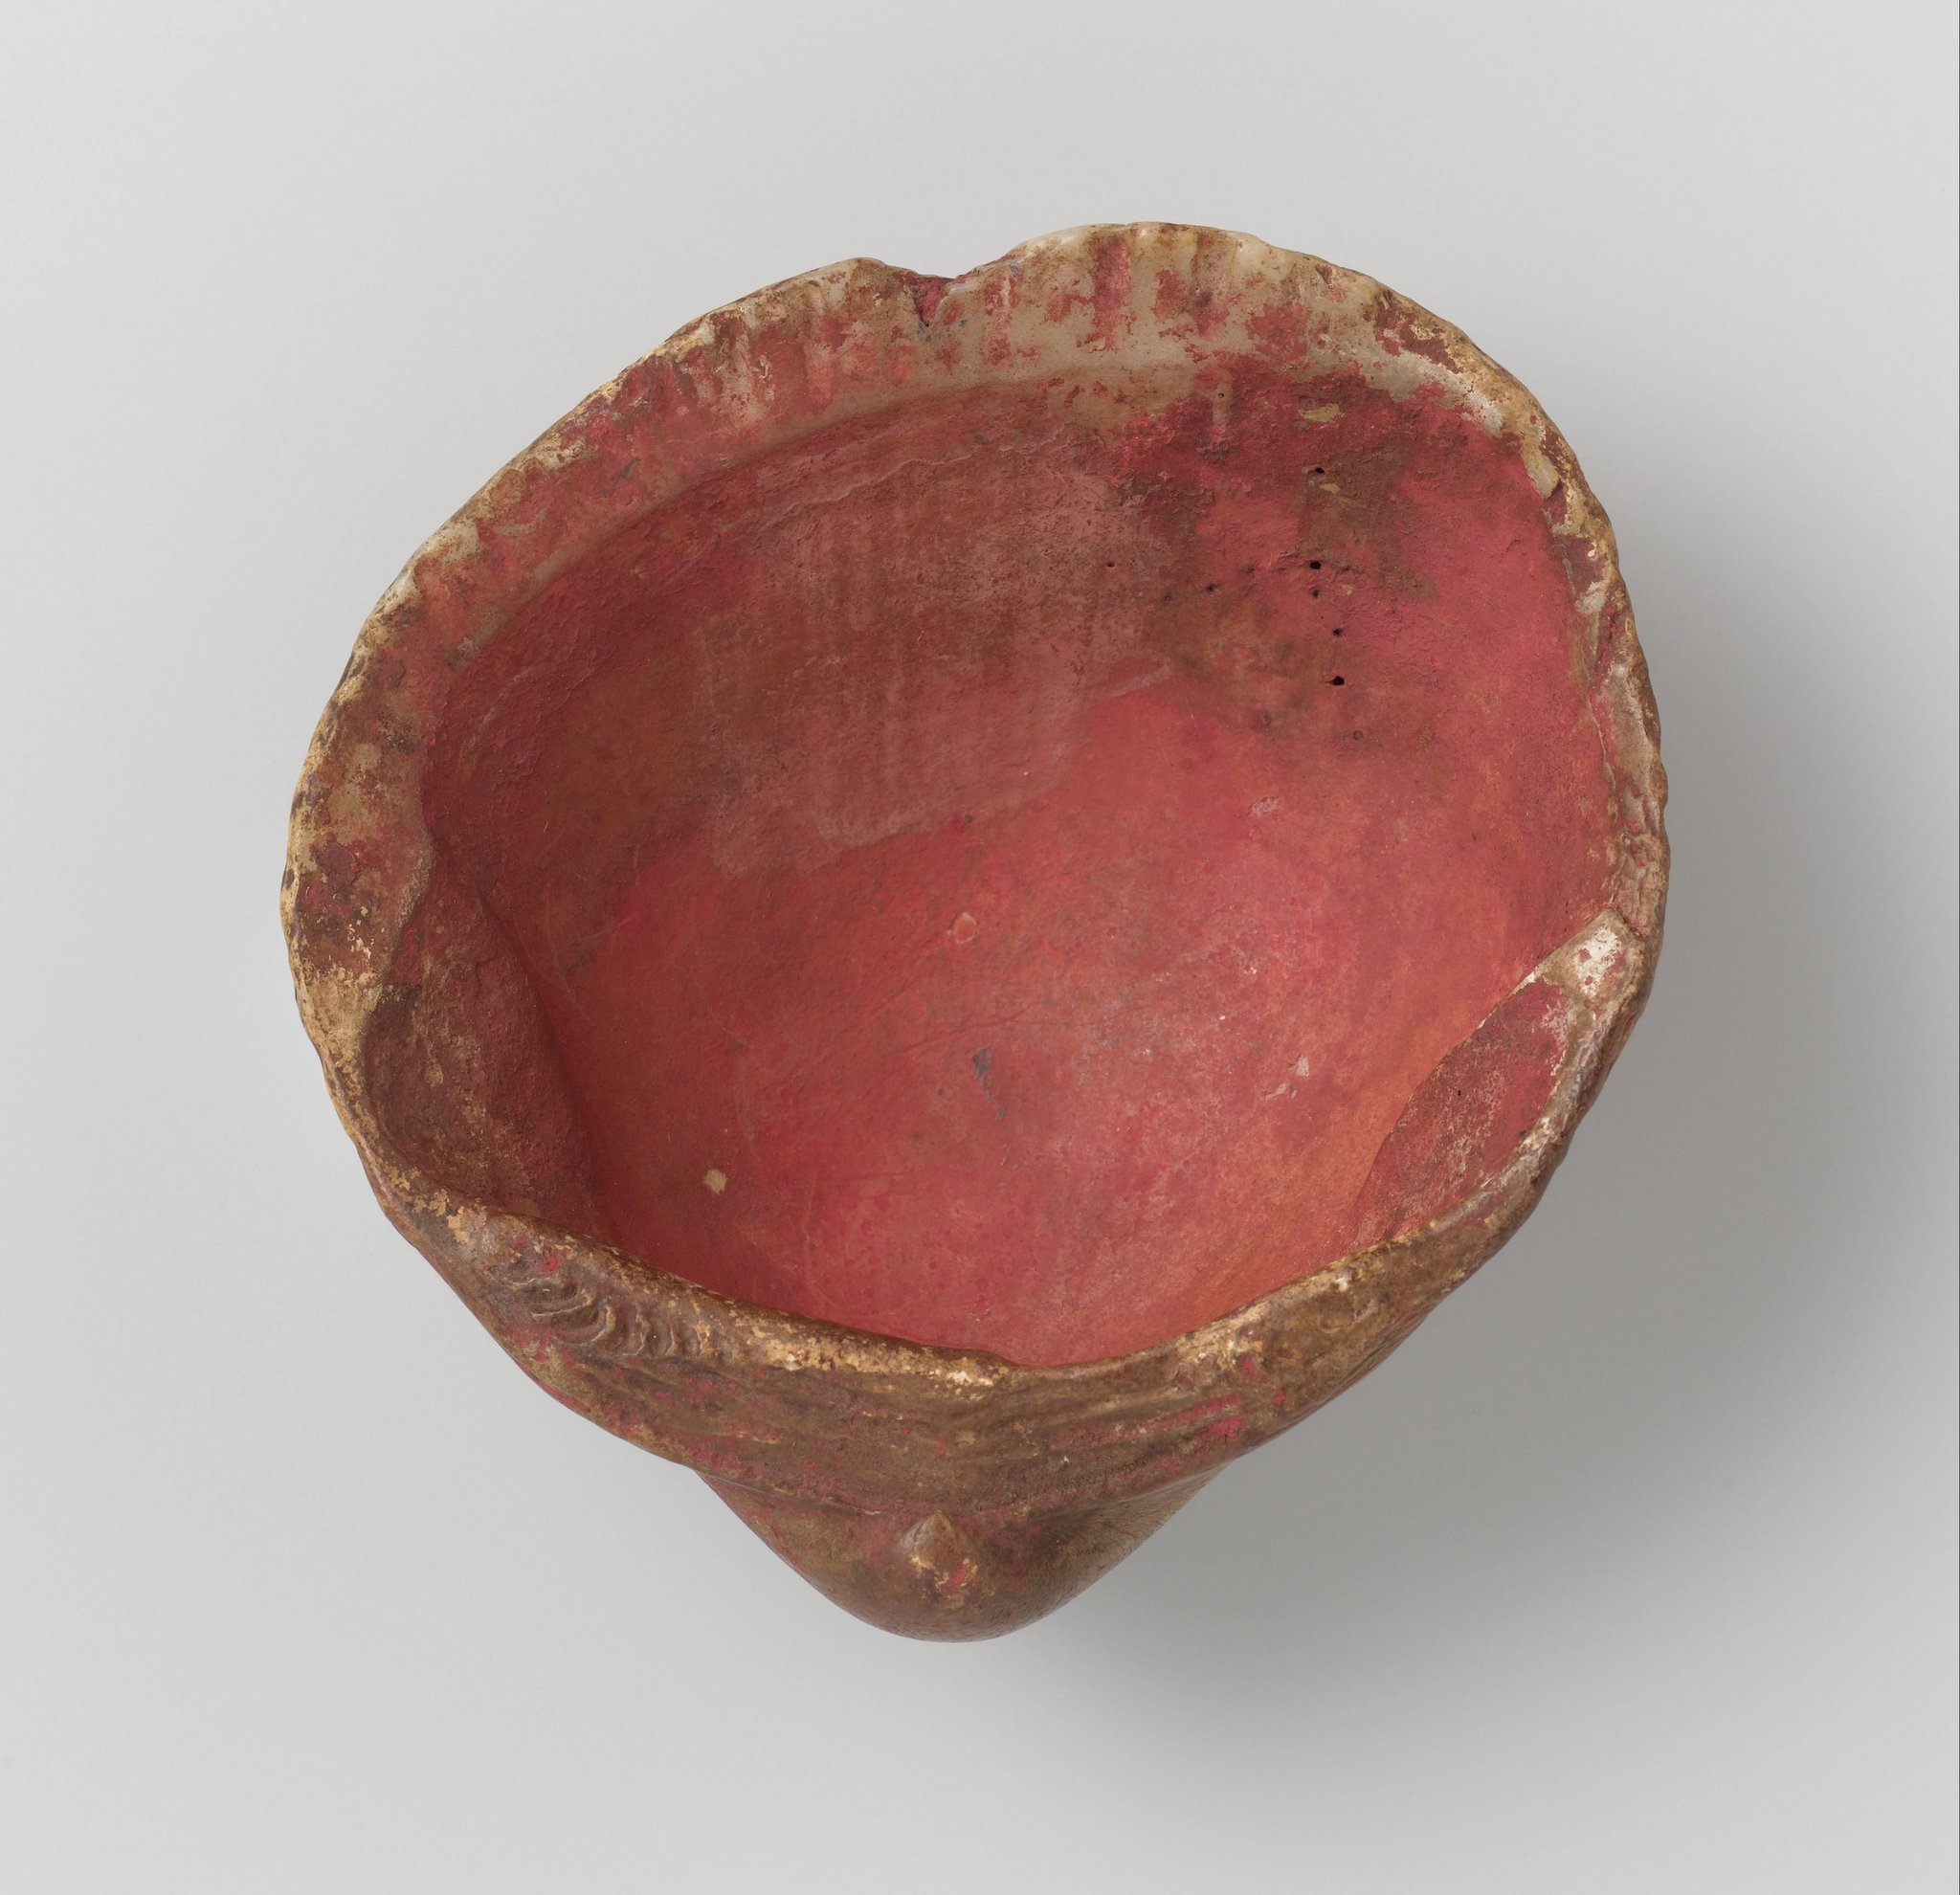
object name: shell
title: Schelp met resten rode verf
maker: Anonymous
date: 1590-1596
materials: shell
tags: willem barendsz., amsterdam, jacob van heemskerck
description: Schelp, verfschelp met resten rode verf.